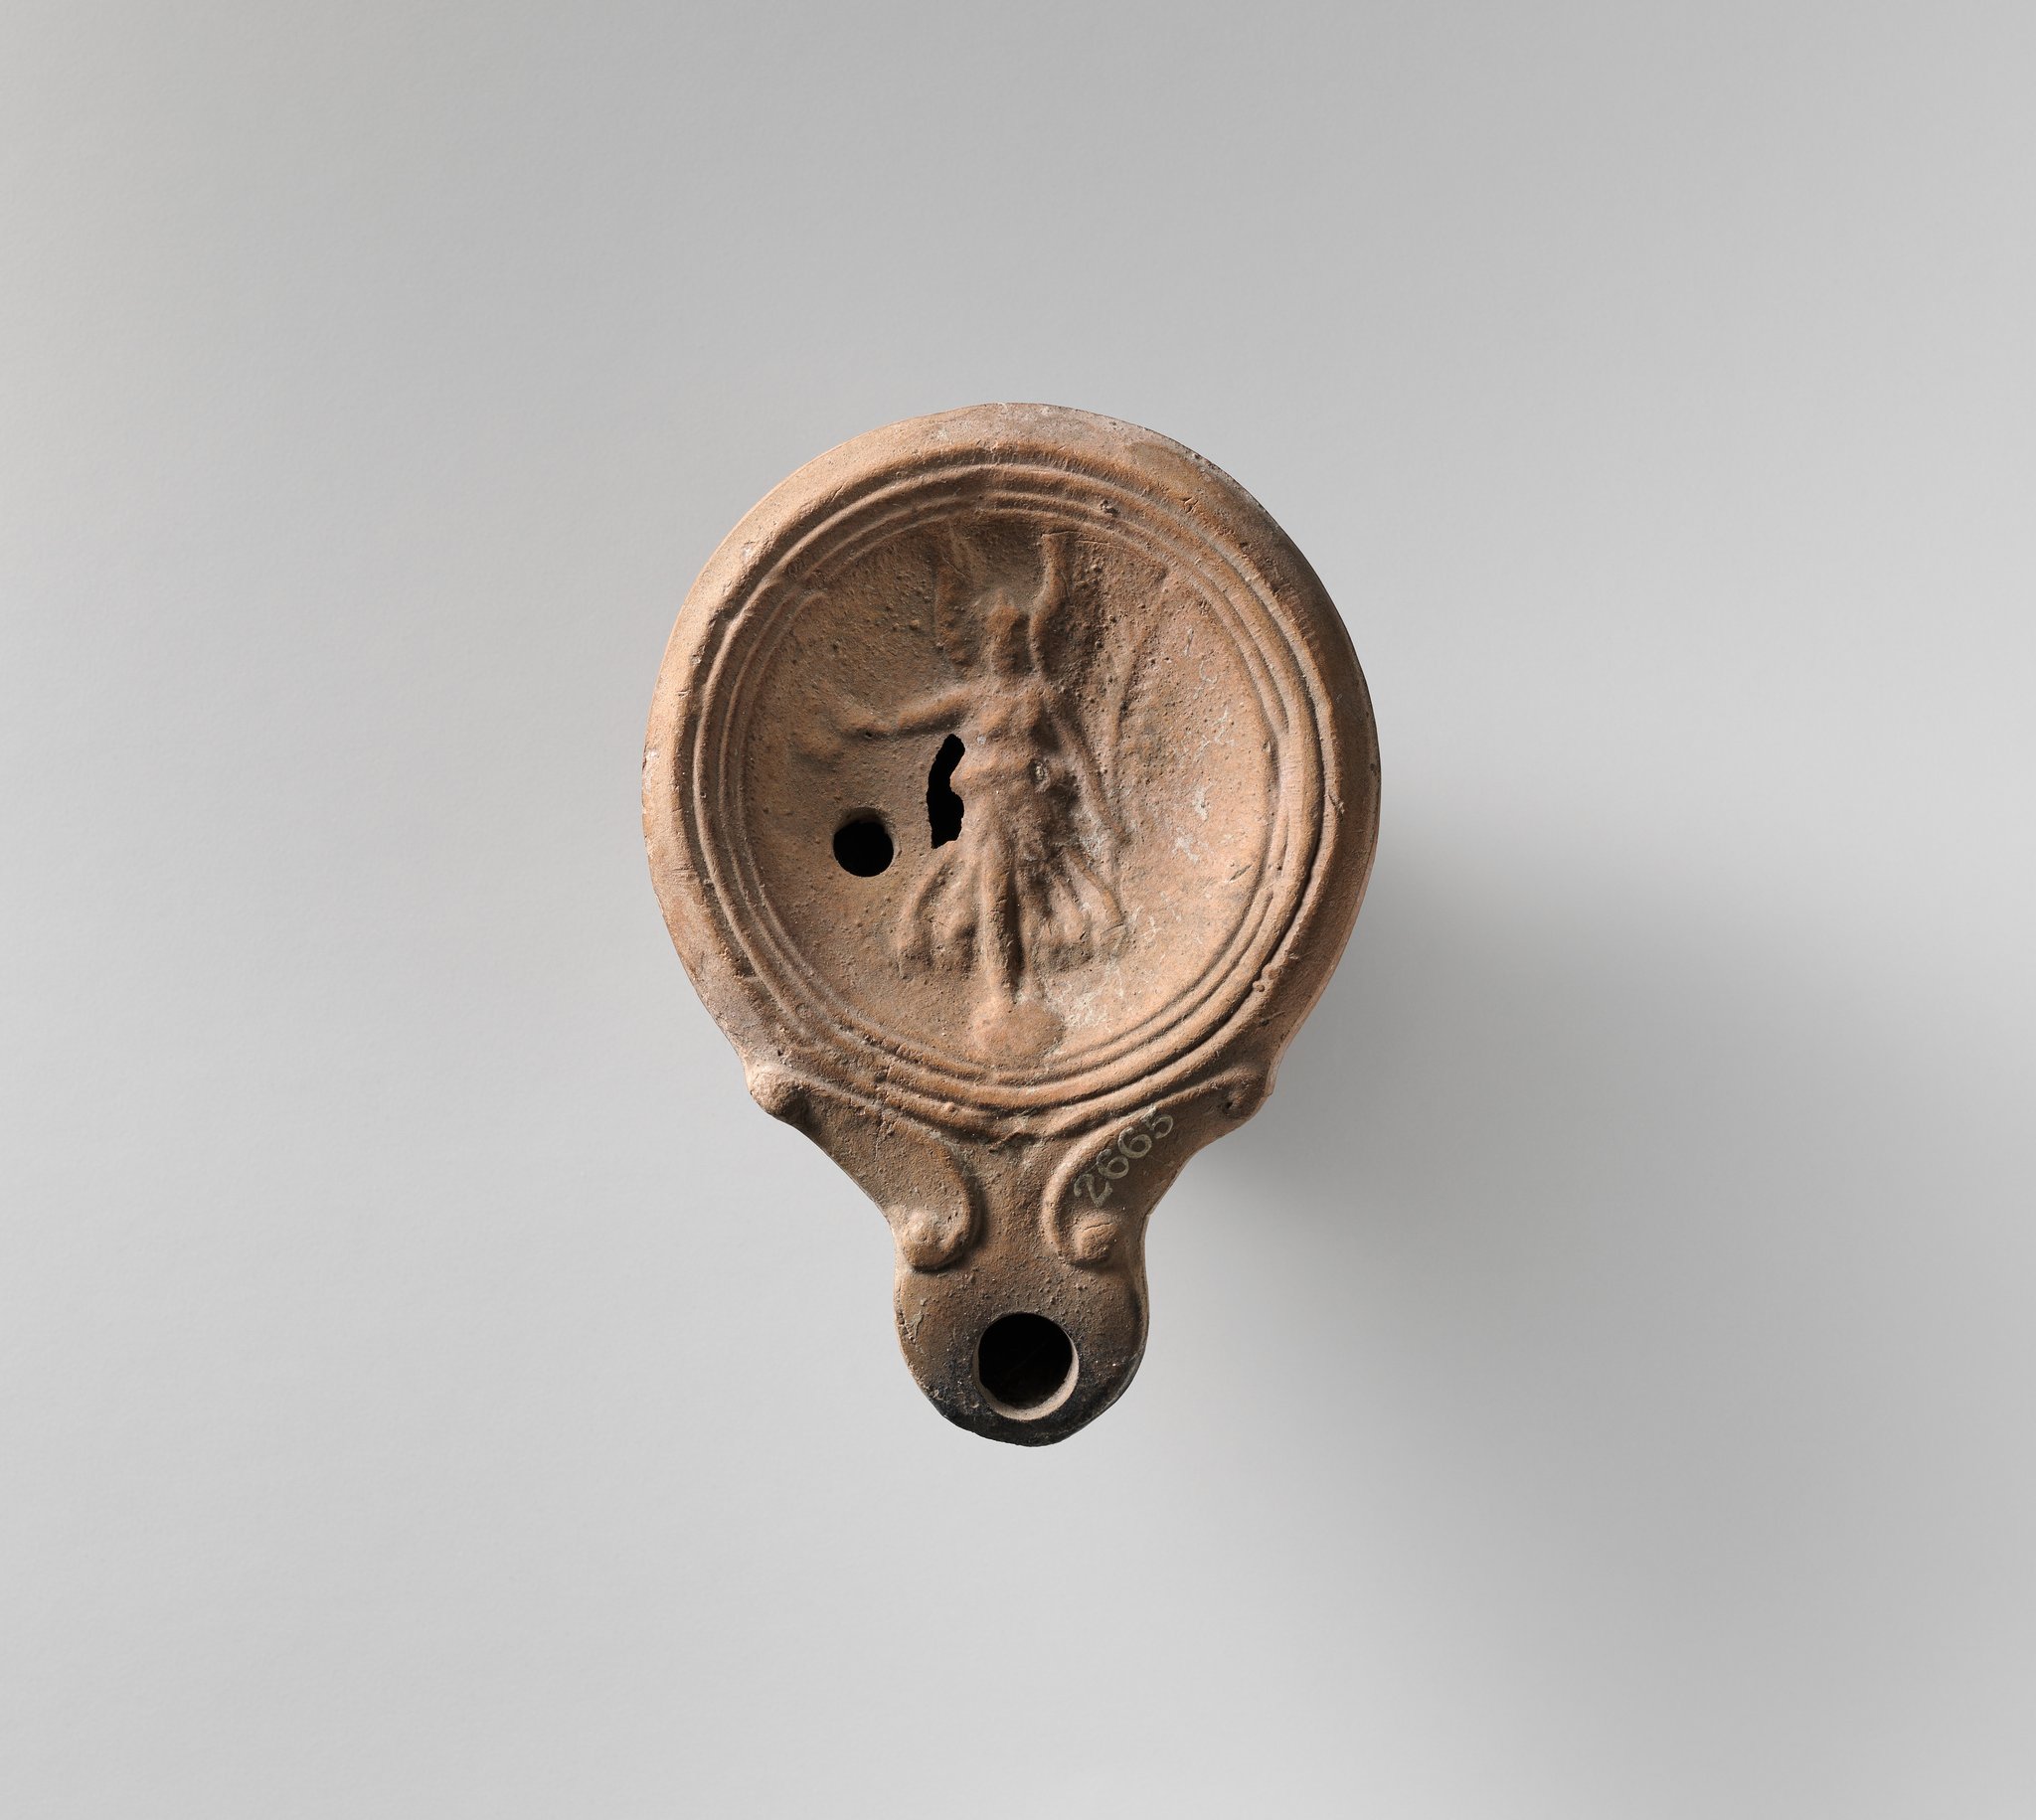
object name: lamp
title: Terracotta oil lamp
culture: roman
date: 40-100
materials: terracotta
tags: nike